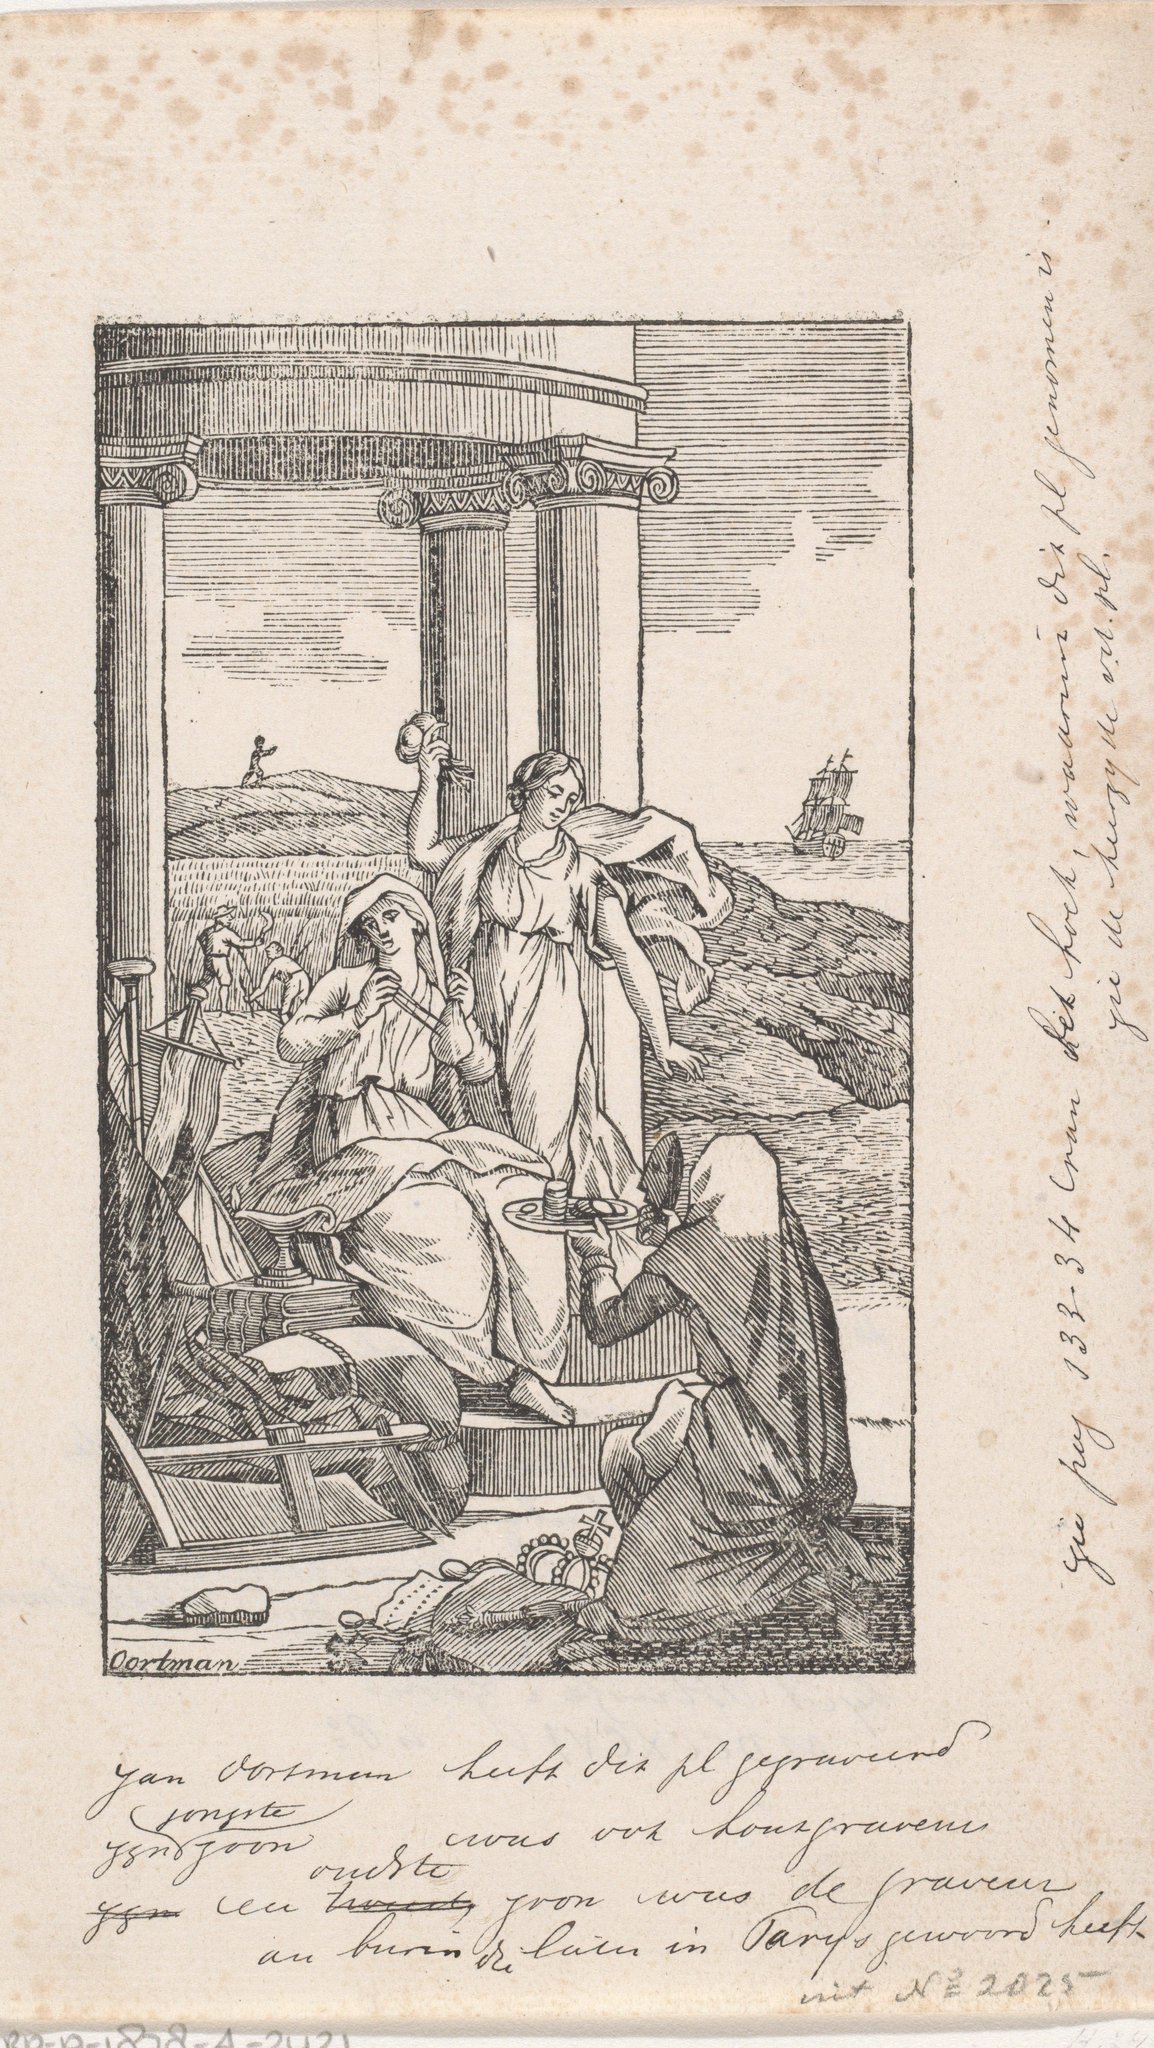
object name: print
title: Illustratie voor: Arend Fokke Simonsz., De graveur, behelzende eene beknopte handleiding tot de daktylioglyphia, of graveerkunst, 1796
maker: jan oortman (sr.)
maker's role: print maker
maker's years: 1753-1823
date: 1796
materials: paper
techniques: woodcut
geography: dordrecht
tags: print, e.g.: engraving, etching, lithograph, graphic artist, engraving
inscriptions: collector's mark: Lugt 2228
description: Illustratie voor: Fokke Simonsz., Arend. De graveur, behelzende eene beknopte handleiding tot de daktylioglyphia, of graveerkunst. Dordrecht: Abraham Blussé & Zoon, 1796. Houtsnede afkomstig uit hoofdstuk acht van Fokke Simonsz's publicatie; een hoofdstuk over de techniek van het houtgraveren.